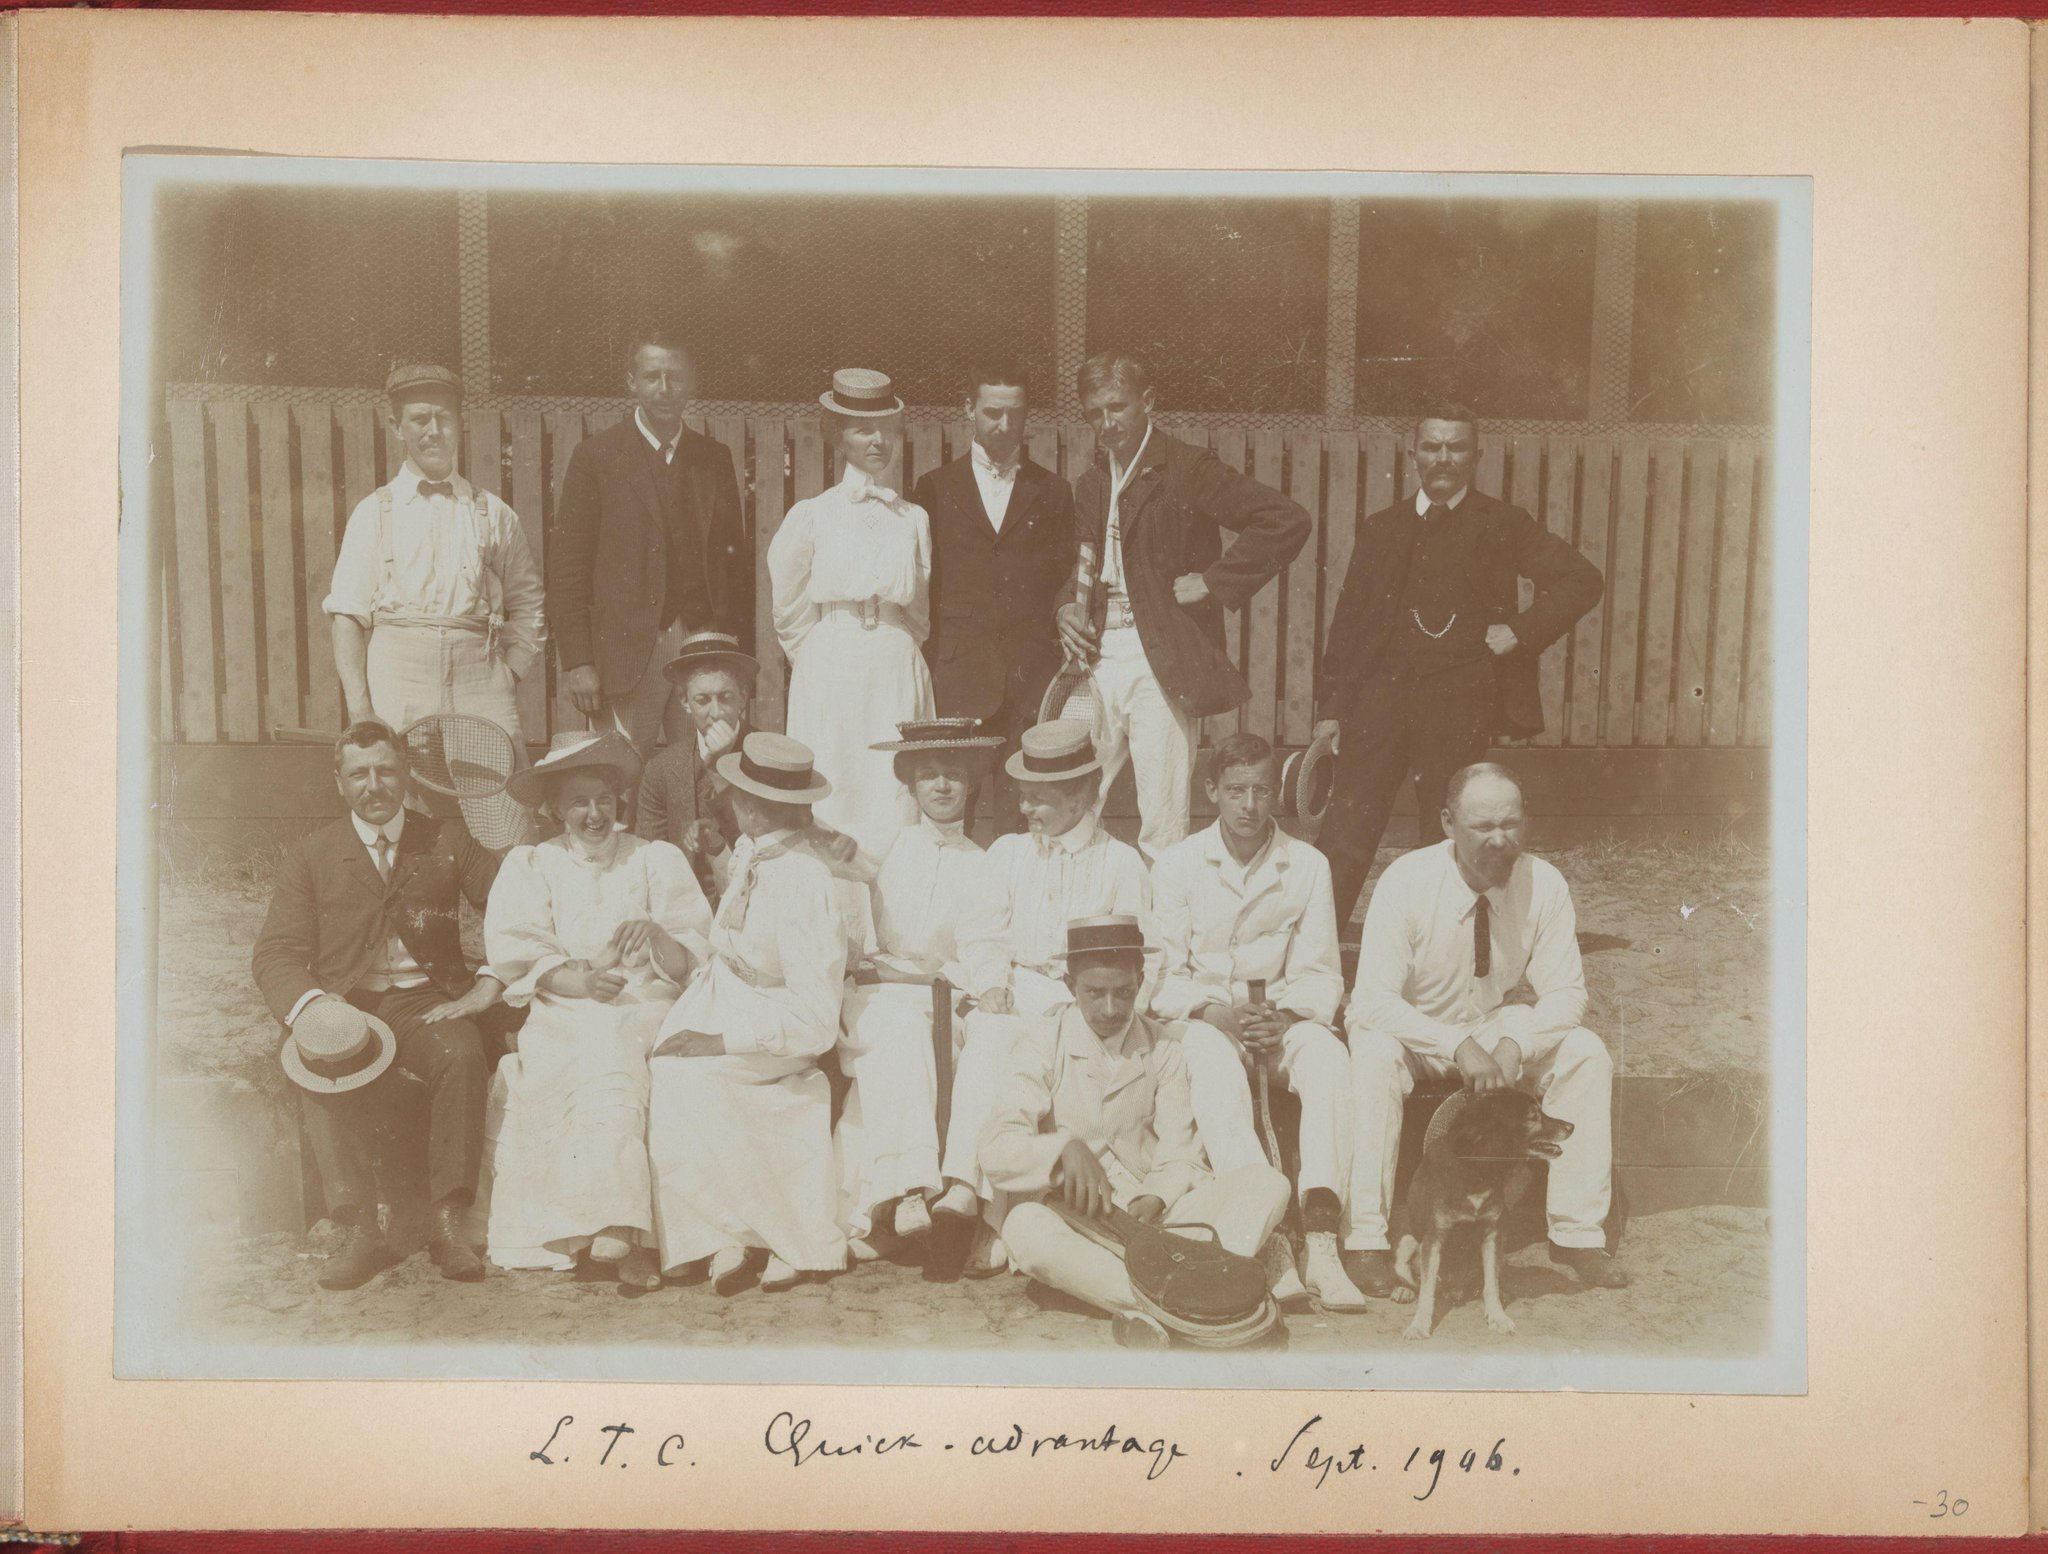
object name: photograph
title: Groep op tennisclub L.T.C. Quick-Advantage, Gerard Aalbersberg zittend links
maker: gerard aalbersberg (us)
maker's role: amateurfotograaf, arts, chirurg, gynaecoloog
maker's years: 1870-1934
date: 1906-1909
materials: paper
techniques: collodion silver print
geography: the hague